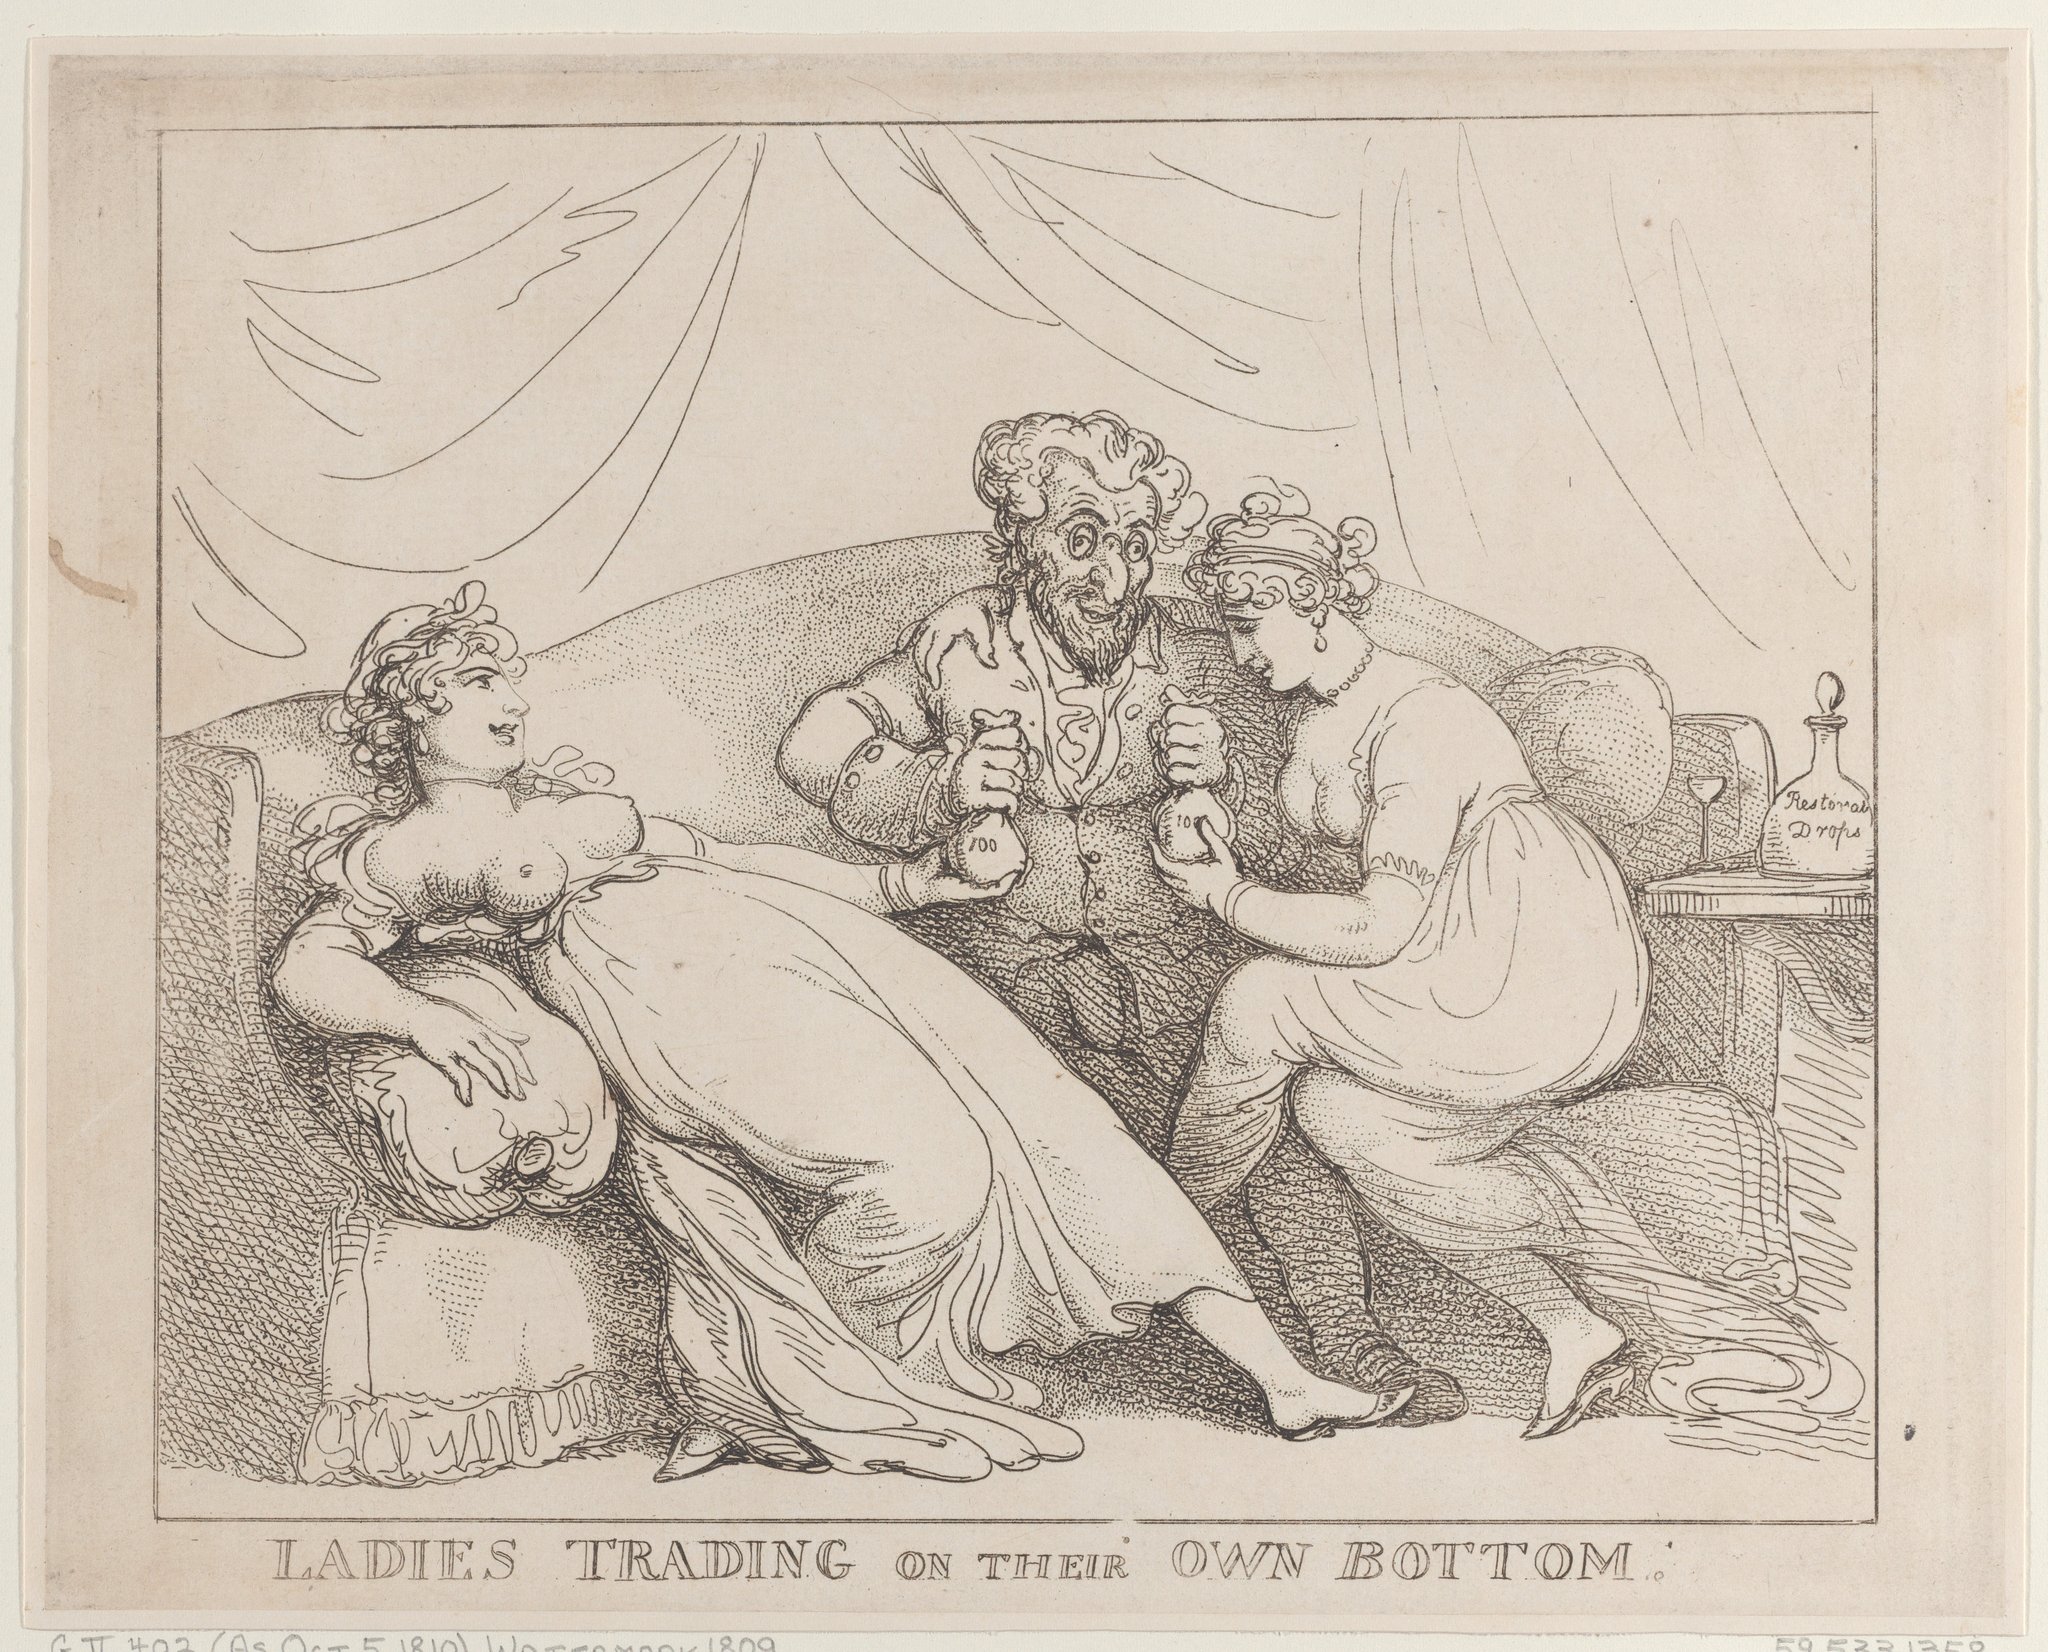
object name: print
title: Ladies Trading on Their Own Bottom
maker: thomas rowlandson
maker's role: artist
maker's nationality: british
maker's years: 1757-1827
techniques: etching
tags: satire,men,women,money,prostitutes